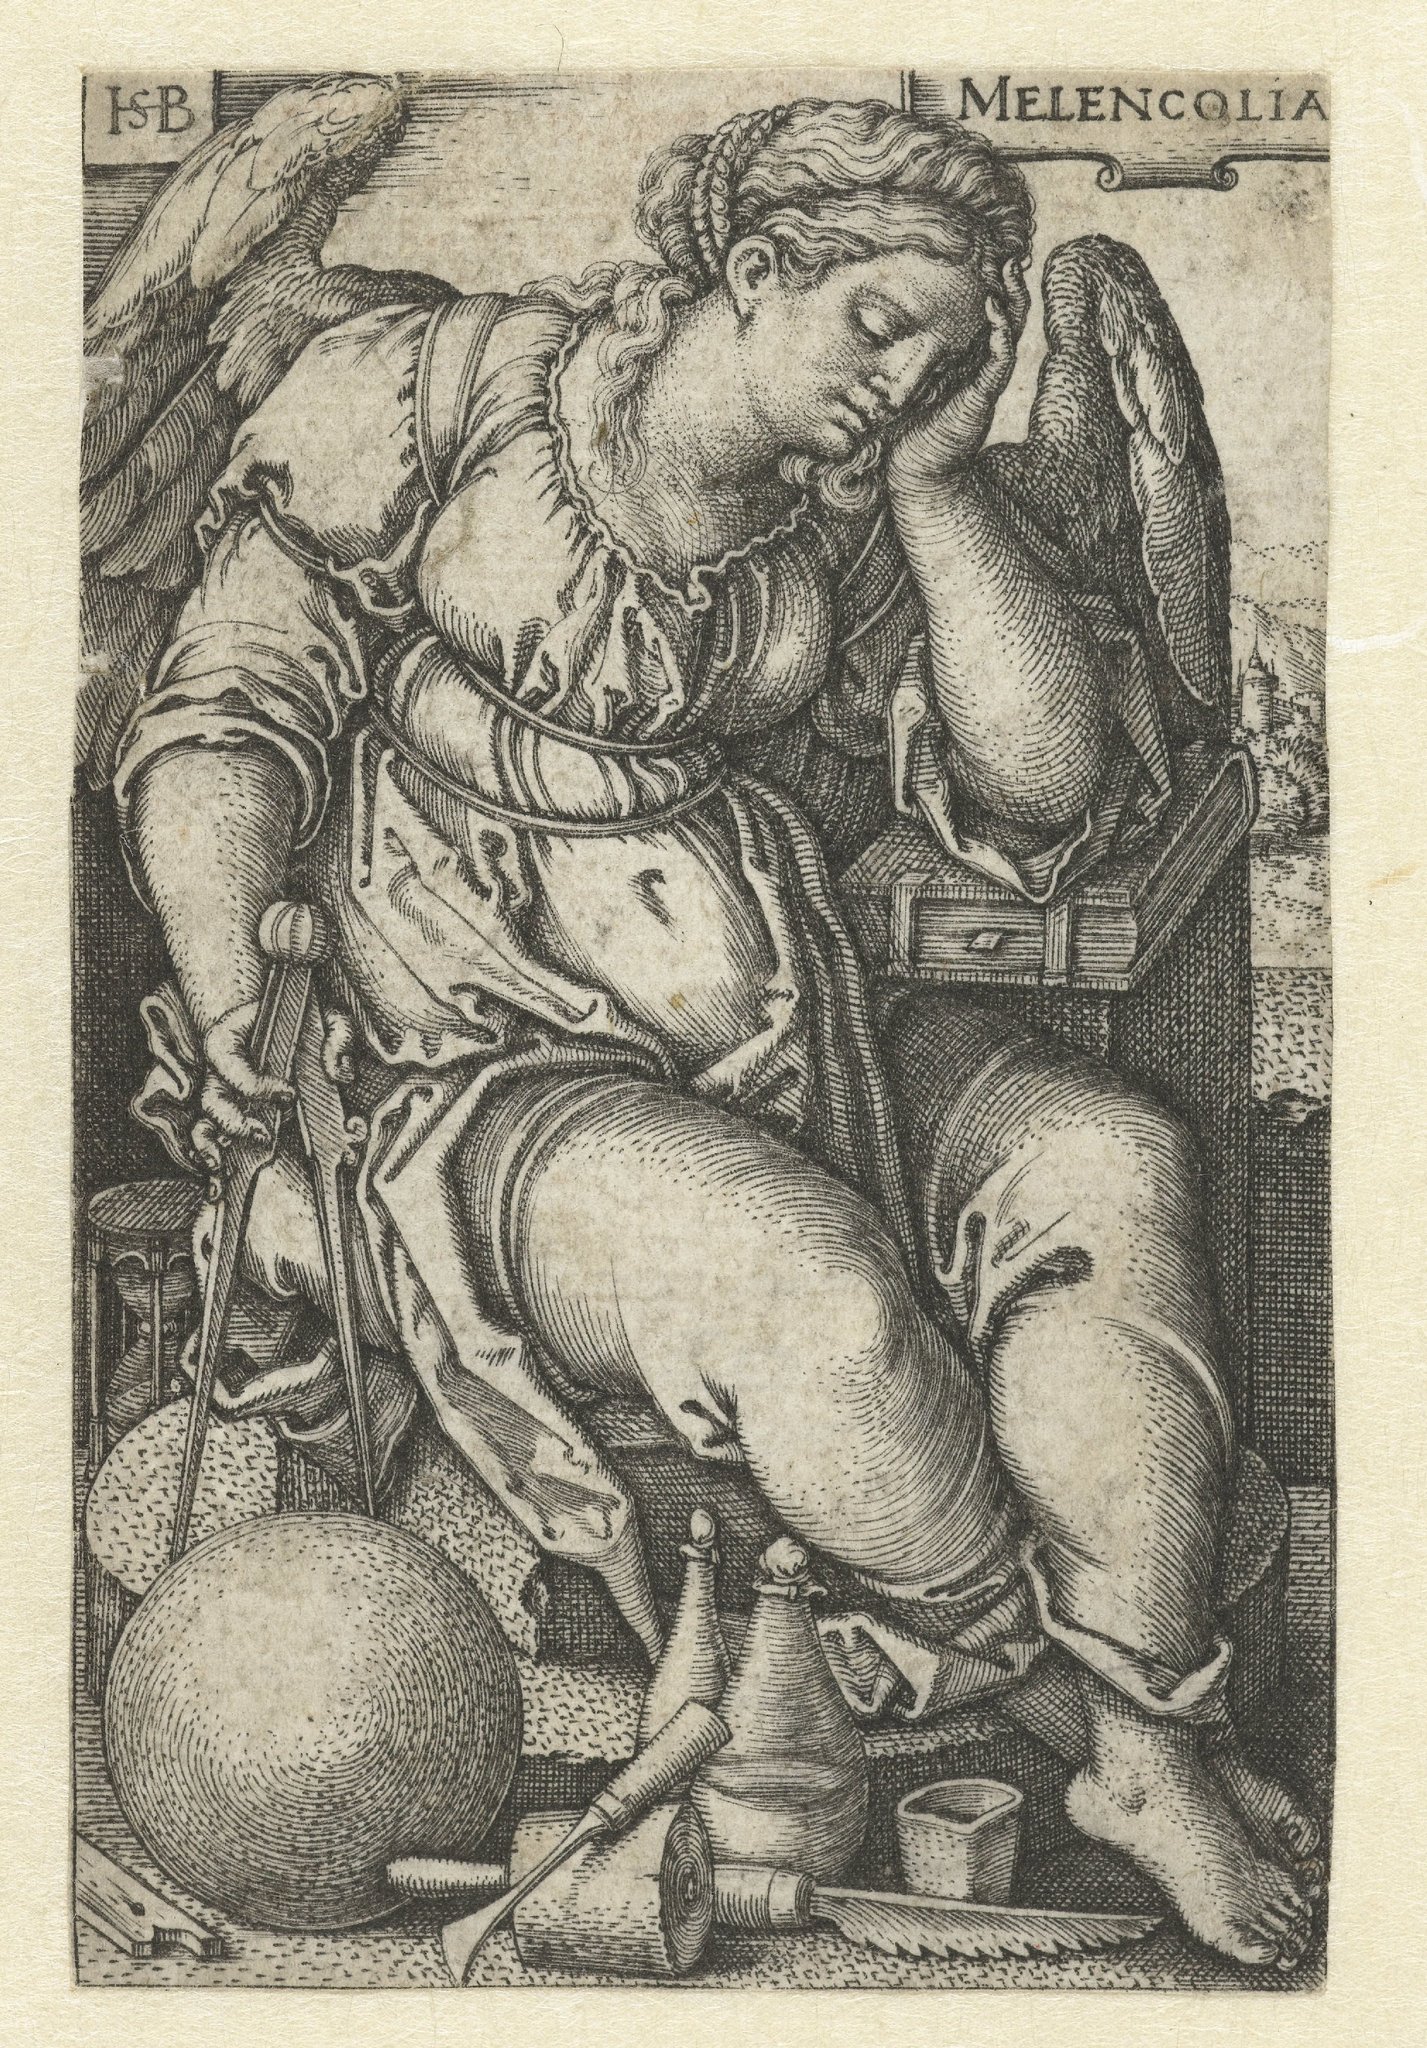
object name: print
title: Melencolia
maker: hans sebald beham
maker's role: designer, draughtsman, print maker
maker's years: 1500-1550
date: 1539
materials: paper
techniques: engraving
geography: frankfurt am main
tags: melancholic temperament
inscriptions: collector's mark: Lugt 2228a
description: Gevleugelde vrouw zittend met haar hoofd ondersteund door haar hand als personificatie van Melancholie met instrumenten van de meetkunde zoals een passer en timmergereedschappen zoals een zaag en hamer.